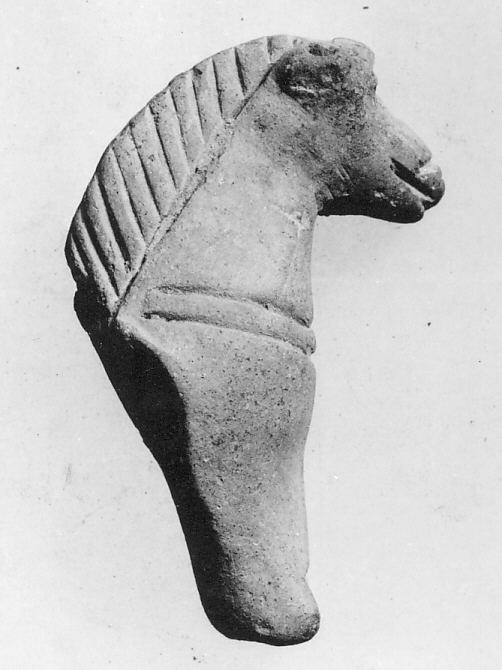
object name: figurine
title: Fragment of a Horse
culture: central asian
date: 1101-1133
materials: terracotta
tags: horses